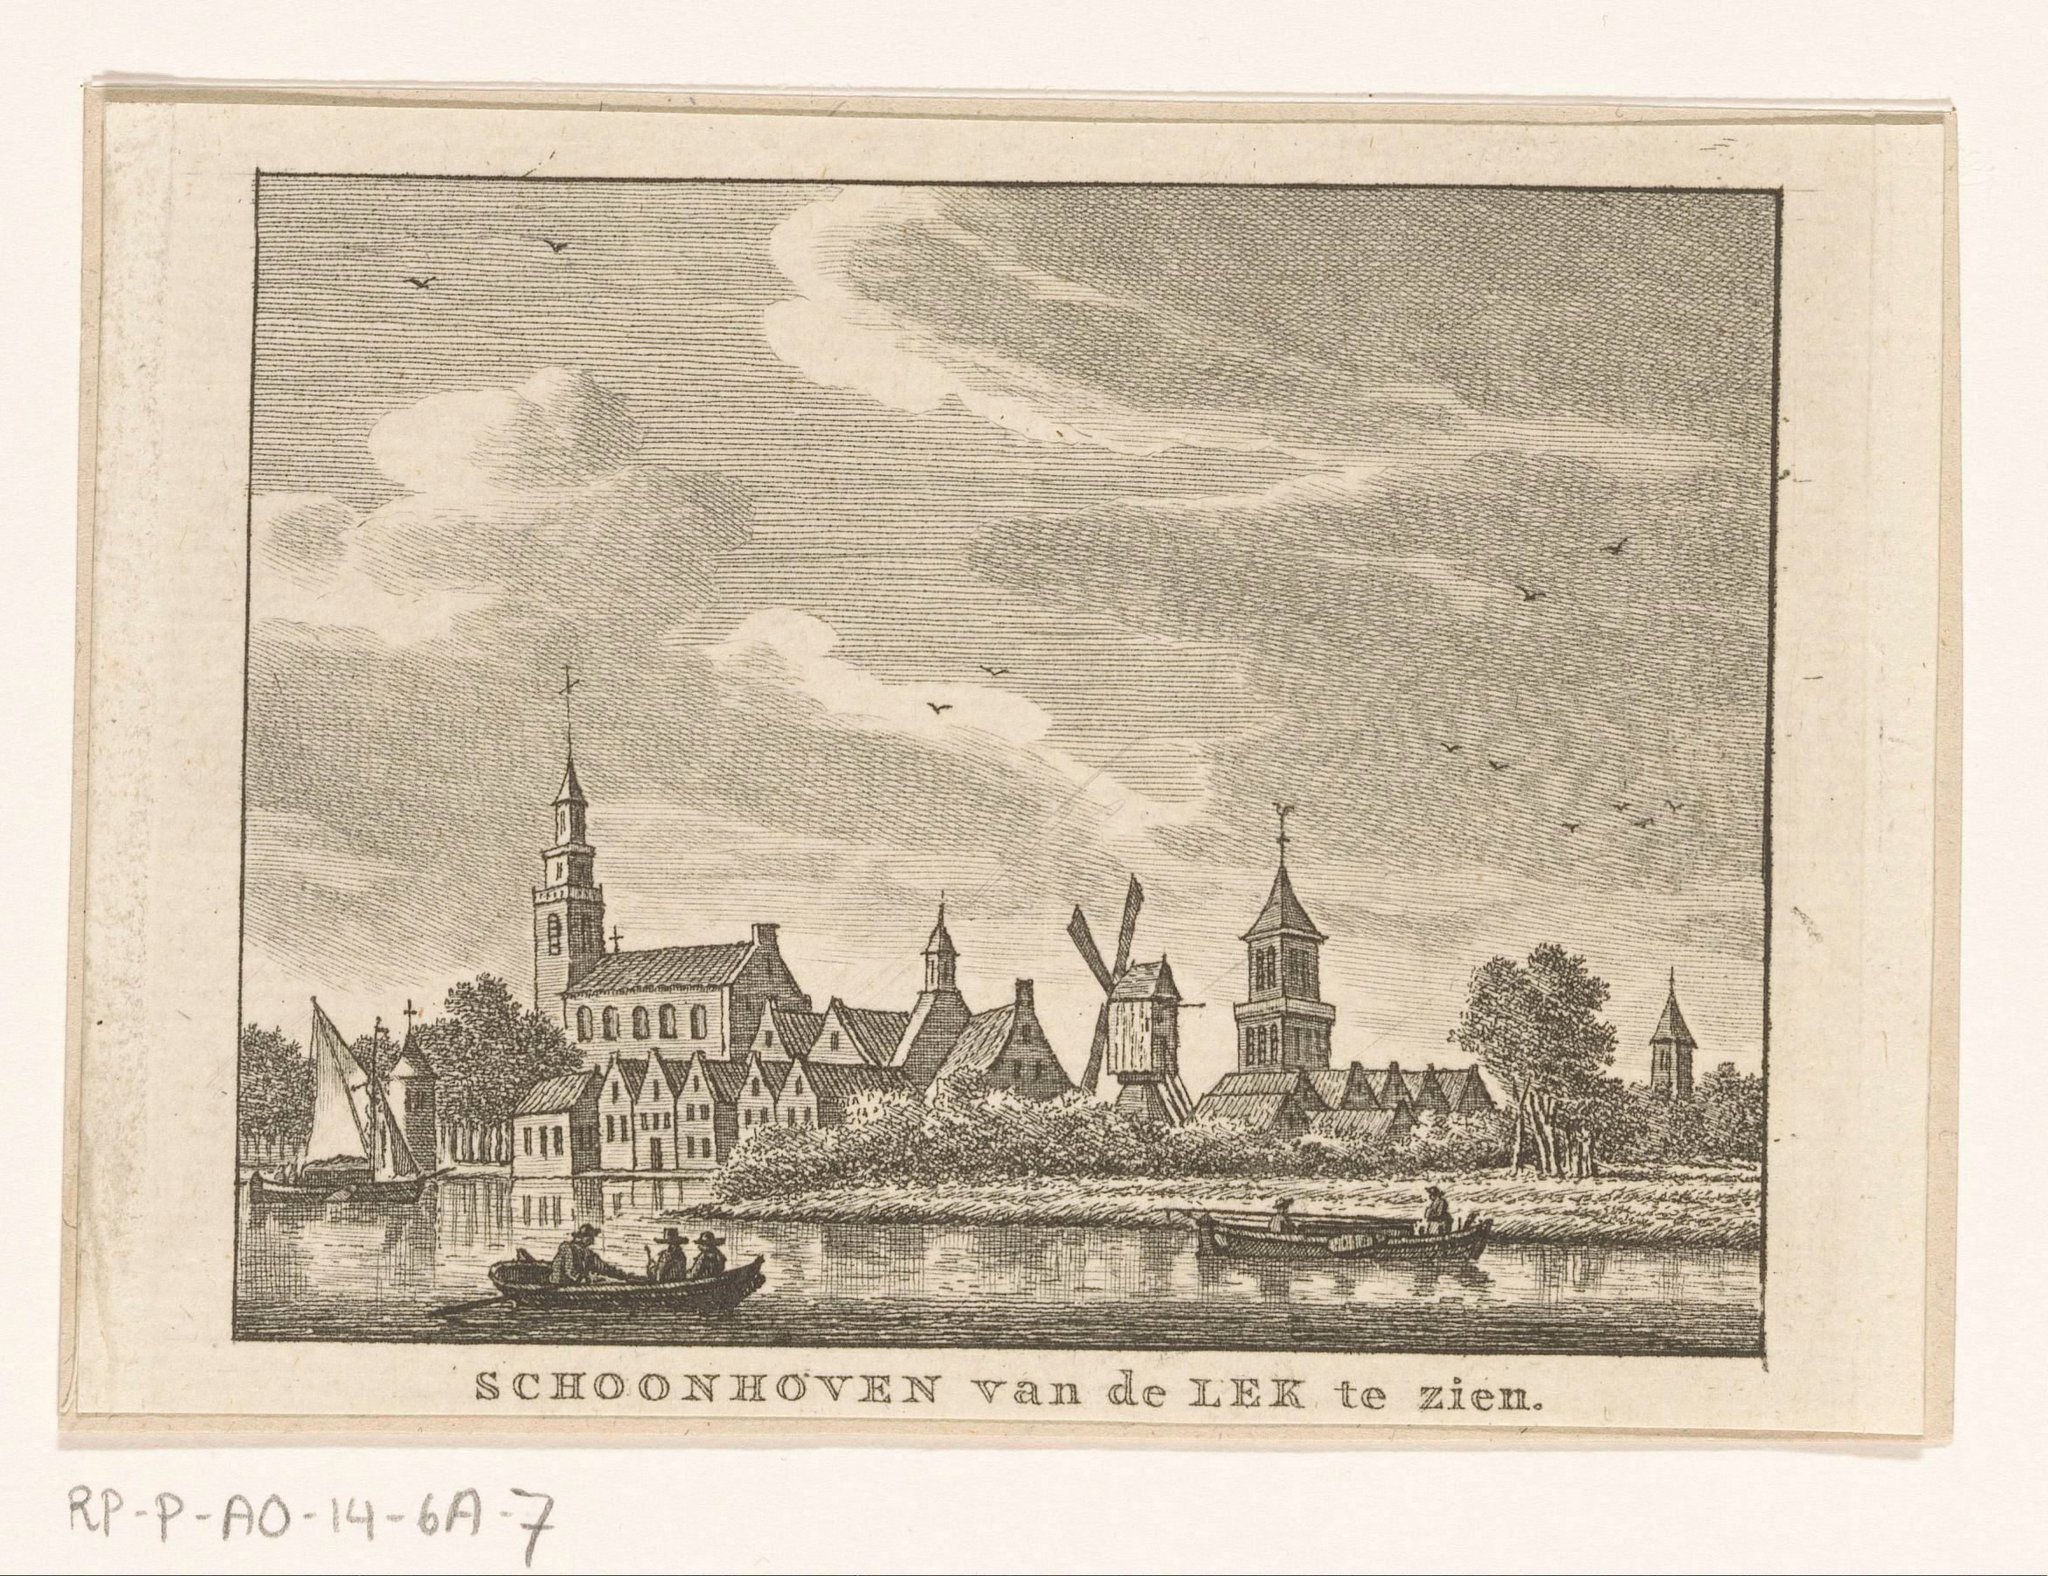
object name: print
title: Schoonhoven van de Lek te zien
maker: carel frederik bendorp (i)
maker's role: print maker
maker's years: 1736-1814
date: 1786-1792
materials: paper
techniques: engraving, etching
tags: church (exterior), windmill, prospect of city, town panorama, silhouette of city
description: Prent uit: Vaderlandsche gezichten, of afbeeldingen van den tegenwoordigen staat der Vereenigde Nederlanden (…). Amsterdam: Hendrik Gartman, Willem Vermandel en Jan Willem Smit, 1786-1792. Uitgegeven in afleveringen met ieder een eigen bifolium en inhoudsopgave. Alle prenten in deze publicatie zijn gegraveerd door Carel Frederik Bendorp (I) en, in de meeste gevallen, gebaseerd op tekeningen van Jan Bulthuis.